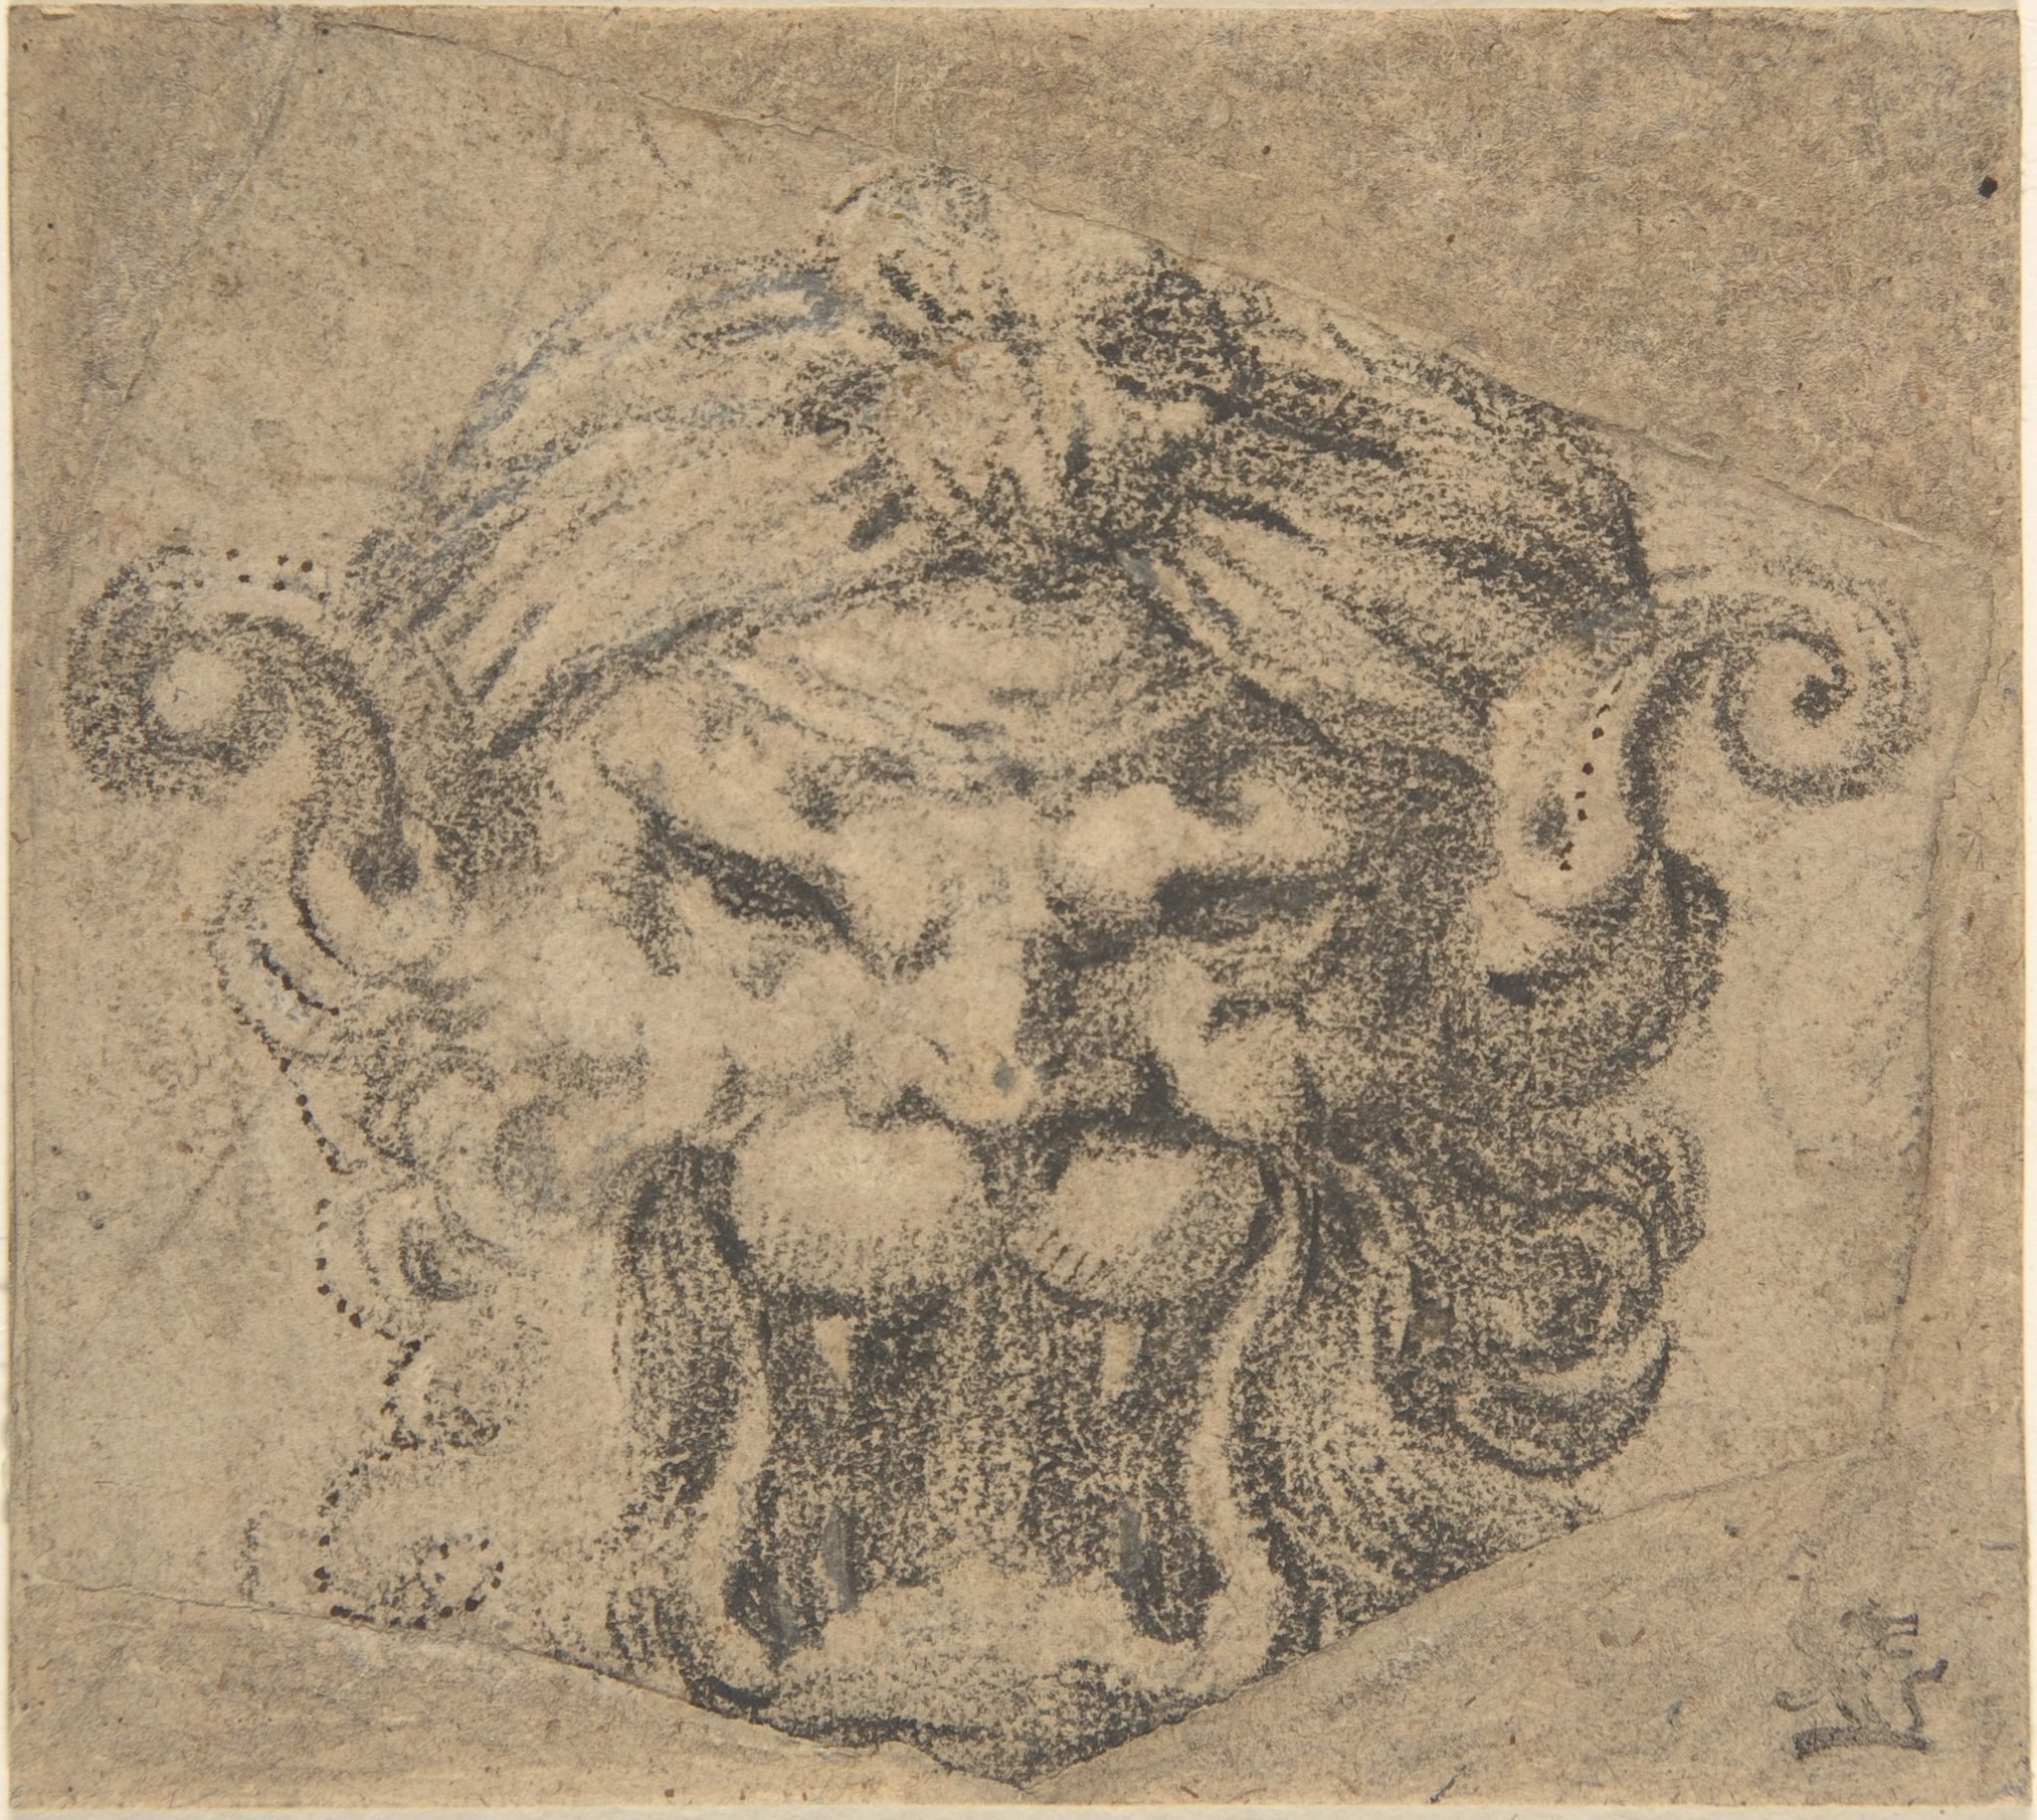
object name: drawing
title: Design for a Leonine Grotesque Head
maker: anonymous, italian, 16th to 17th century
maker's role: artist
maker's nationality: italian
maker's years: 1500-1700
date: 1501-1700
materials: chalk, graphite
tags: lions